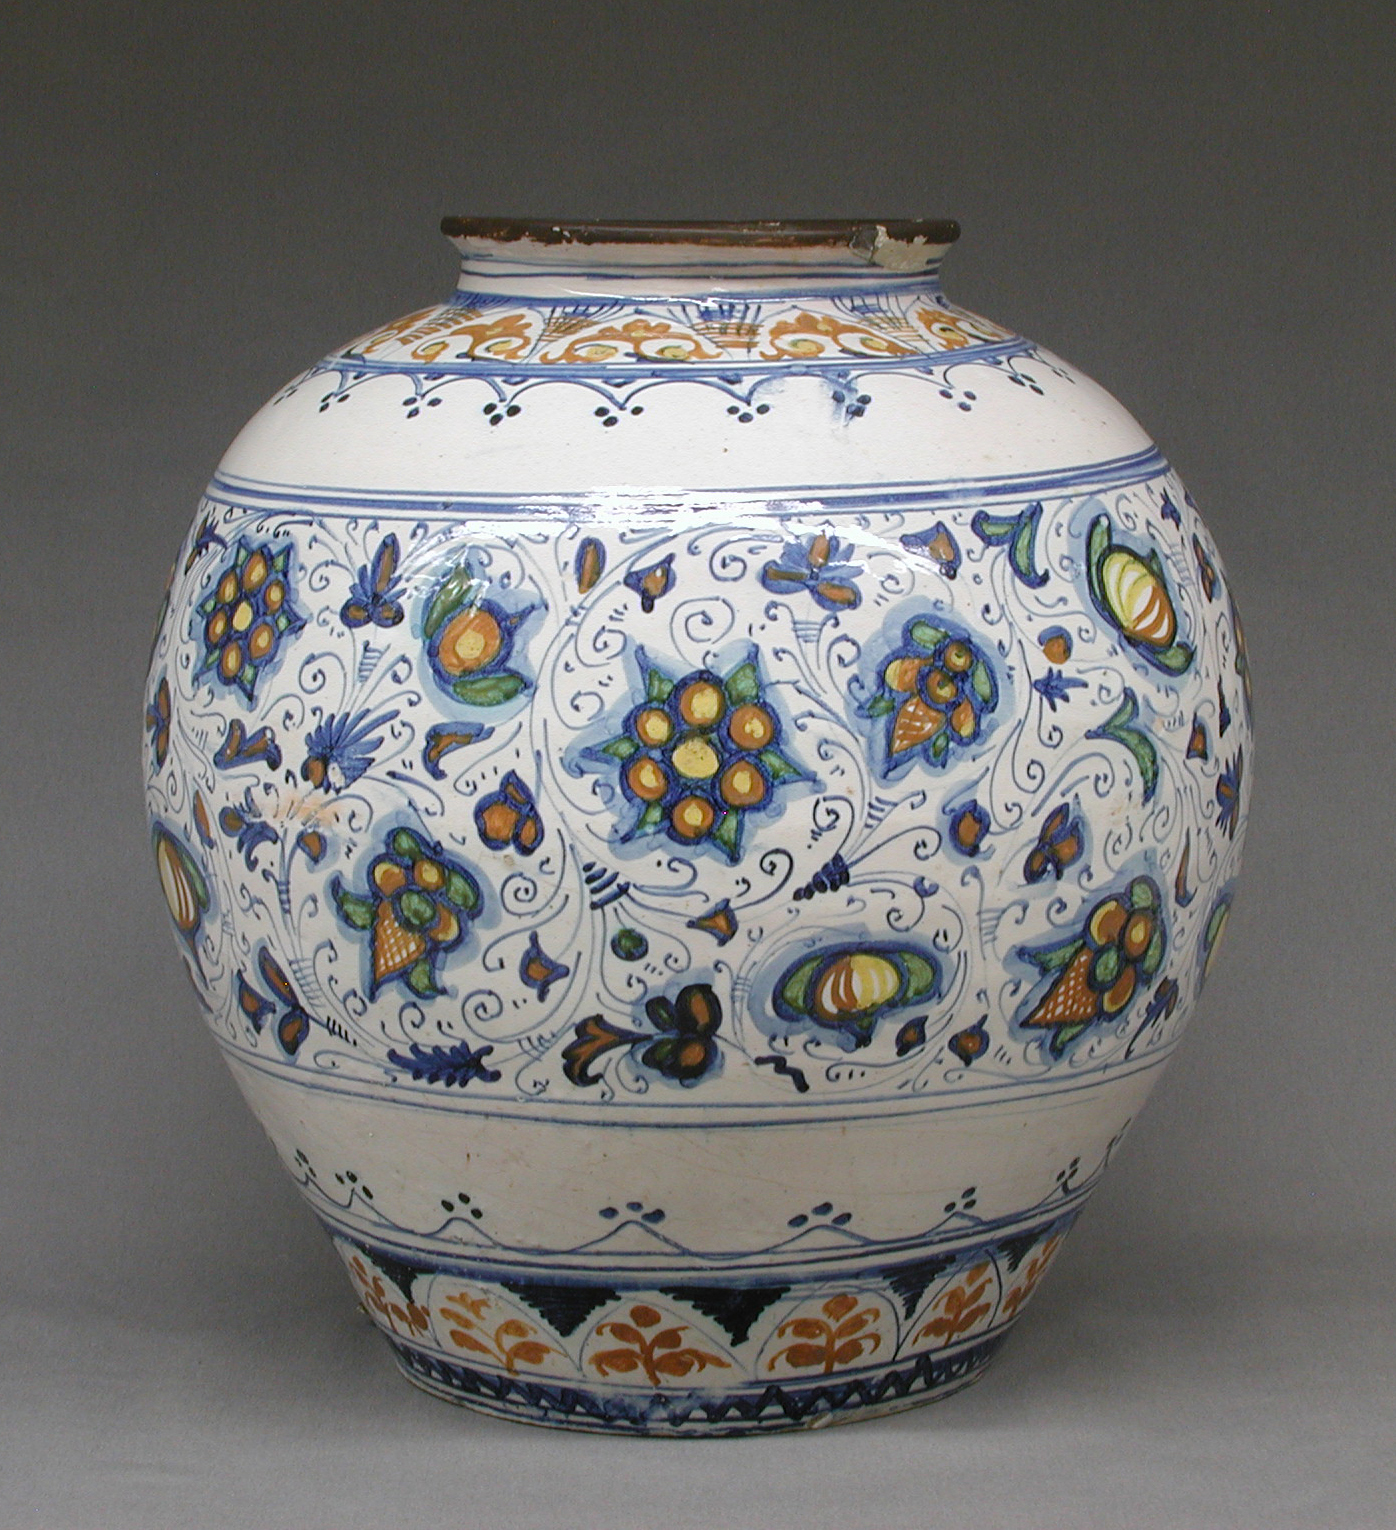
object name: storage jar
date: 1500-1520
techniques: maiolica, glazing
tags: flowers